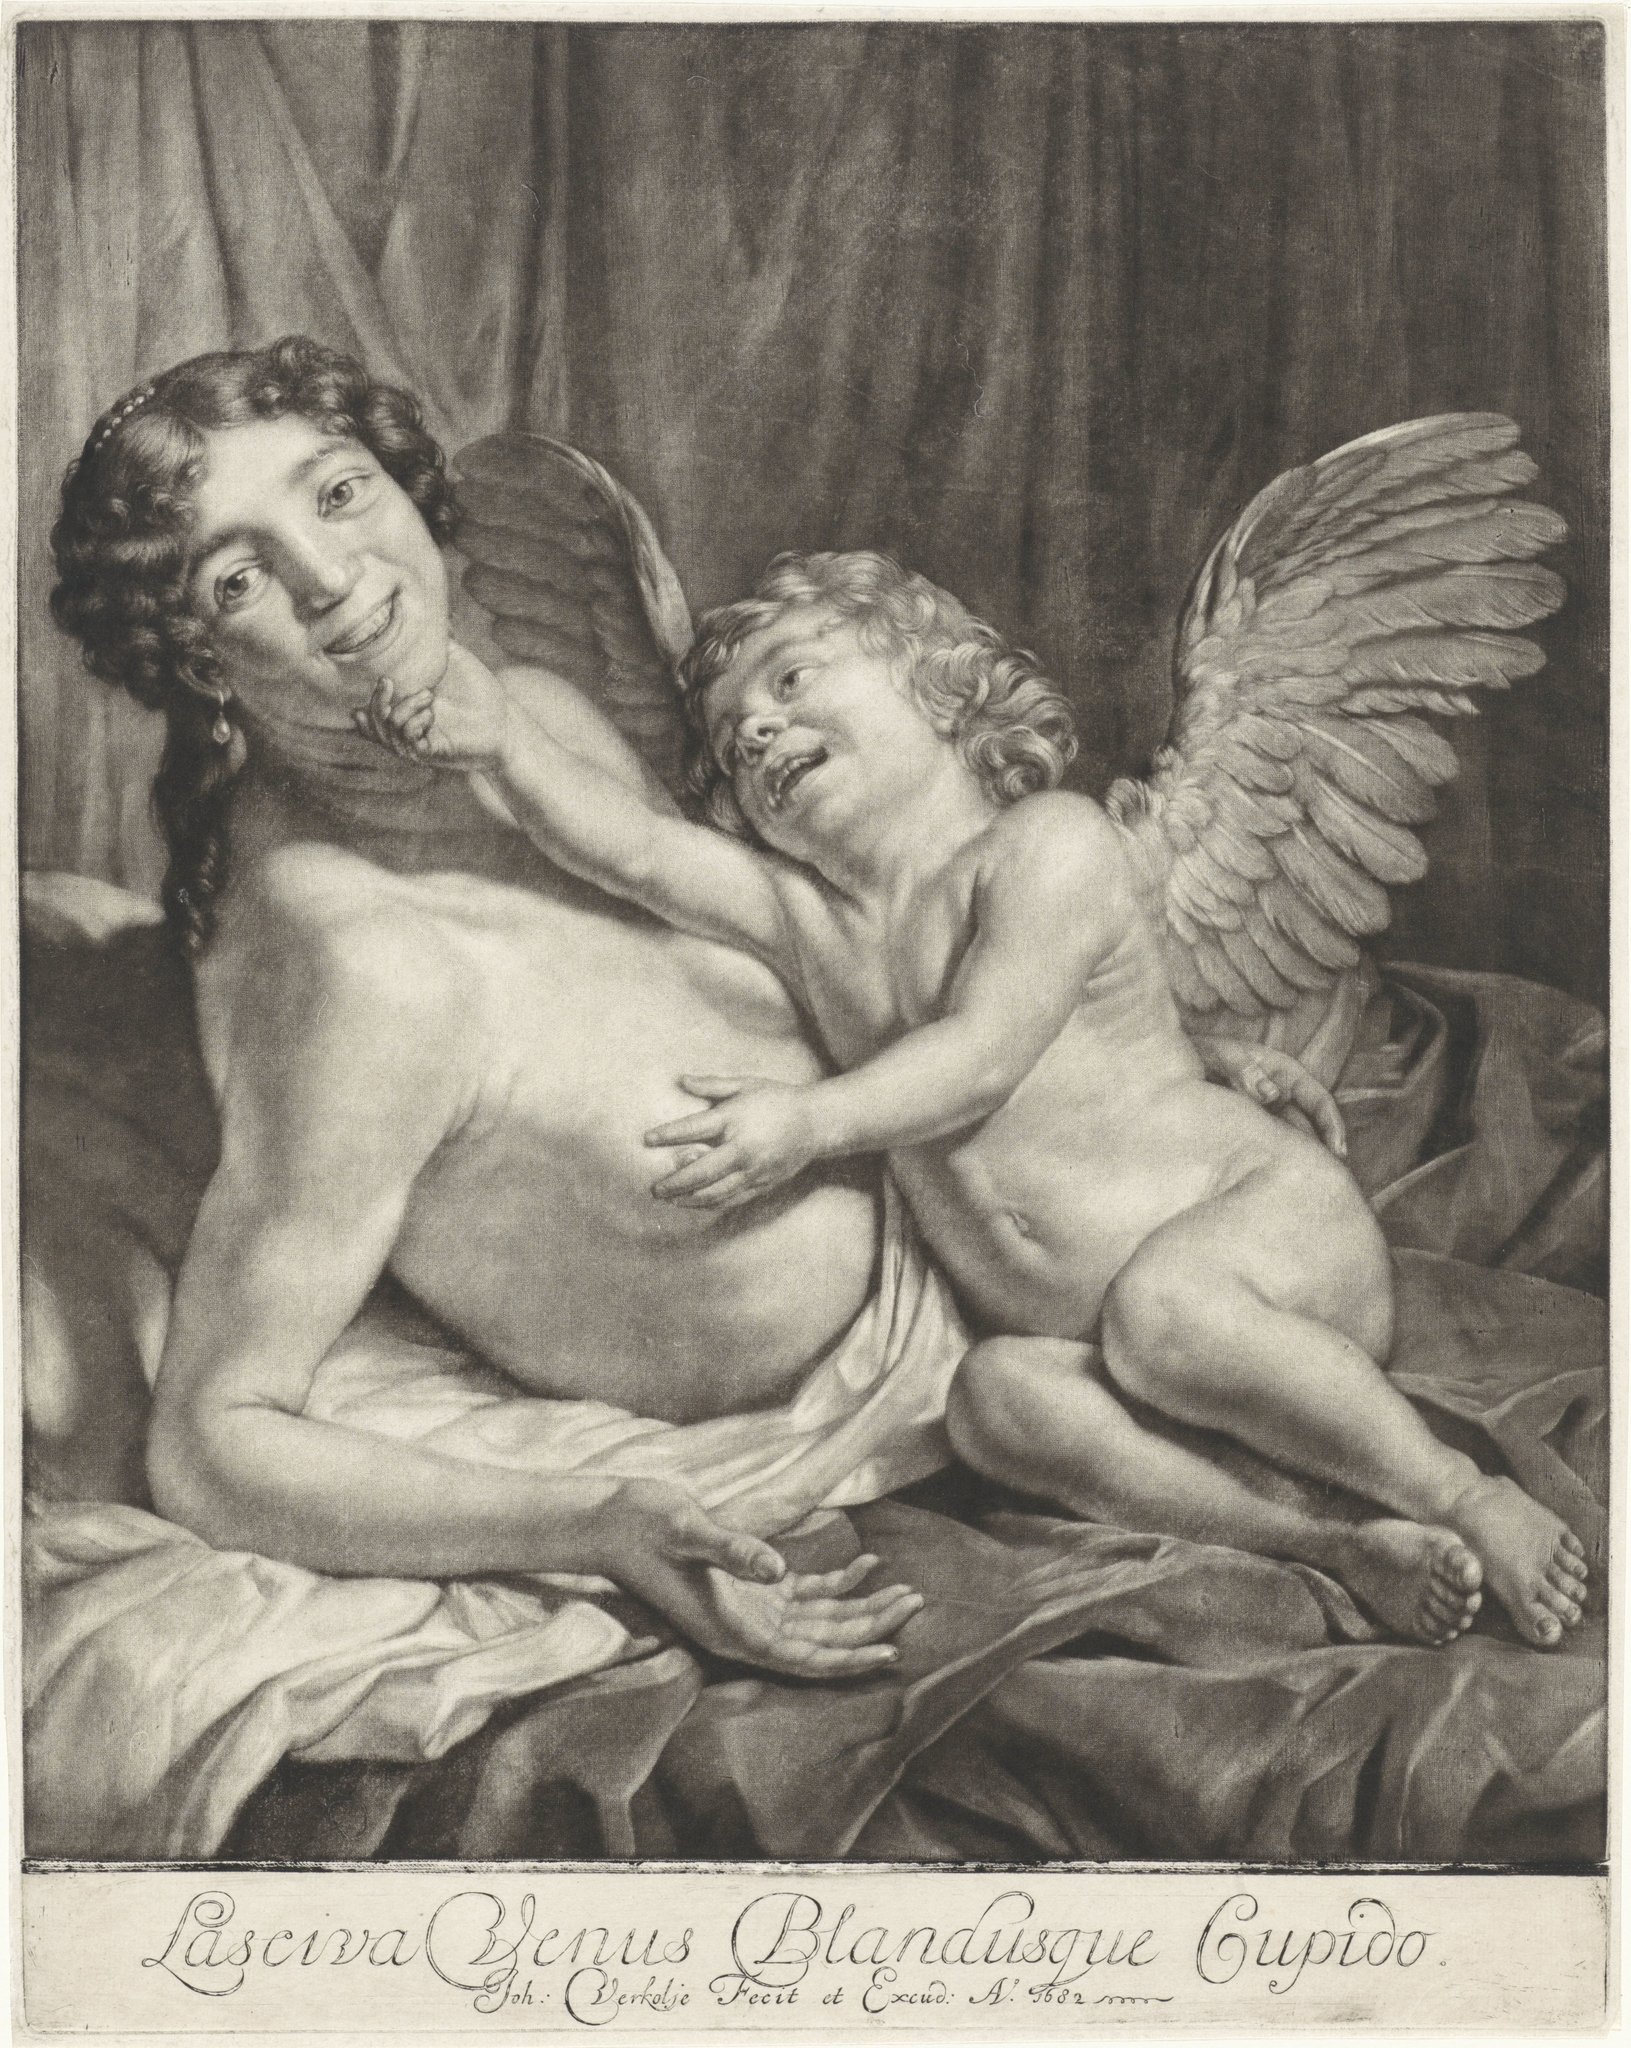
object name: print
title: Lasciva Venus Blandusque Cupido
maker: jan verkolje (i)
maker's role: draughtsman, painter, print maker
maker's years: 1650-1693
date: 1682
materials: paper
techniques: mezzotint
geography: delft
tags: (story of) cupid, amor (eros), (story of) venus (aphrodite)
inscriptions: collector's mark: Lugt 240